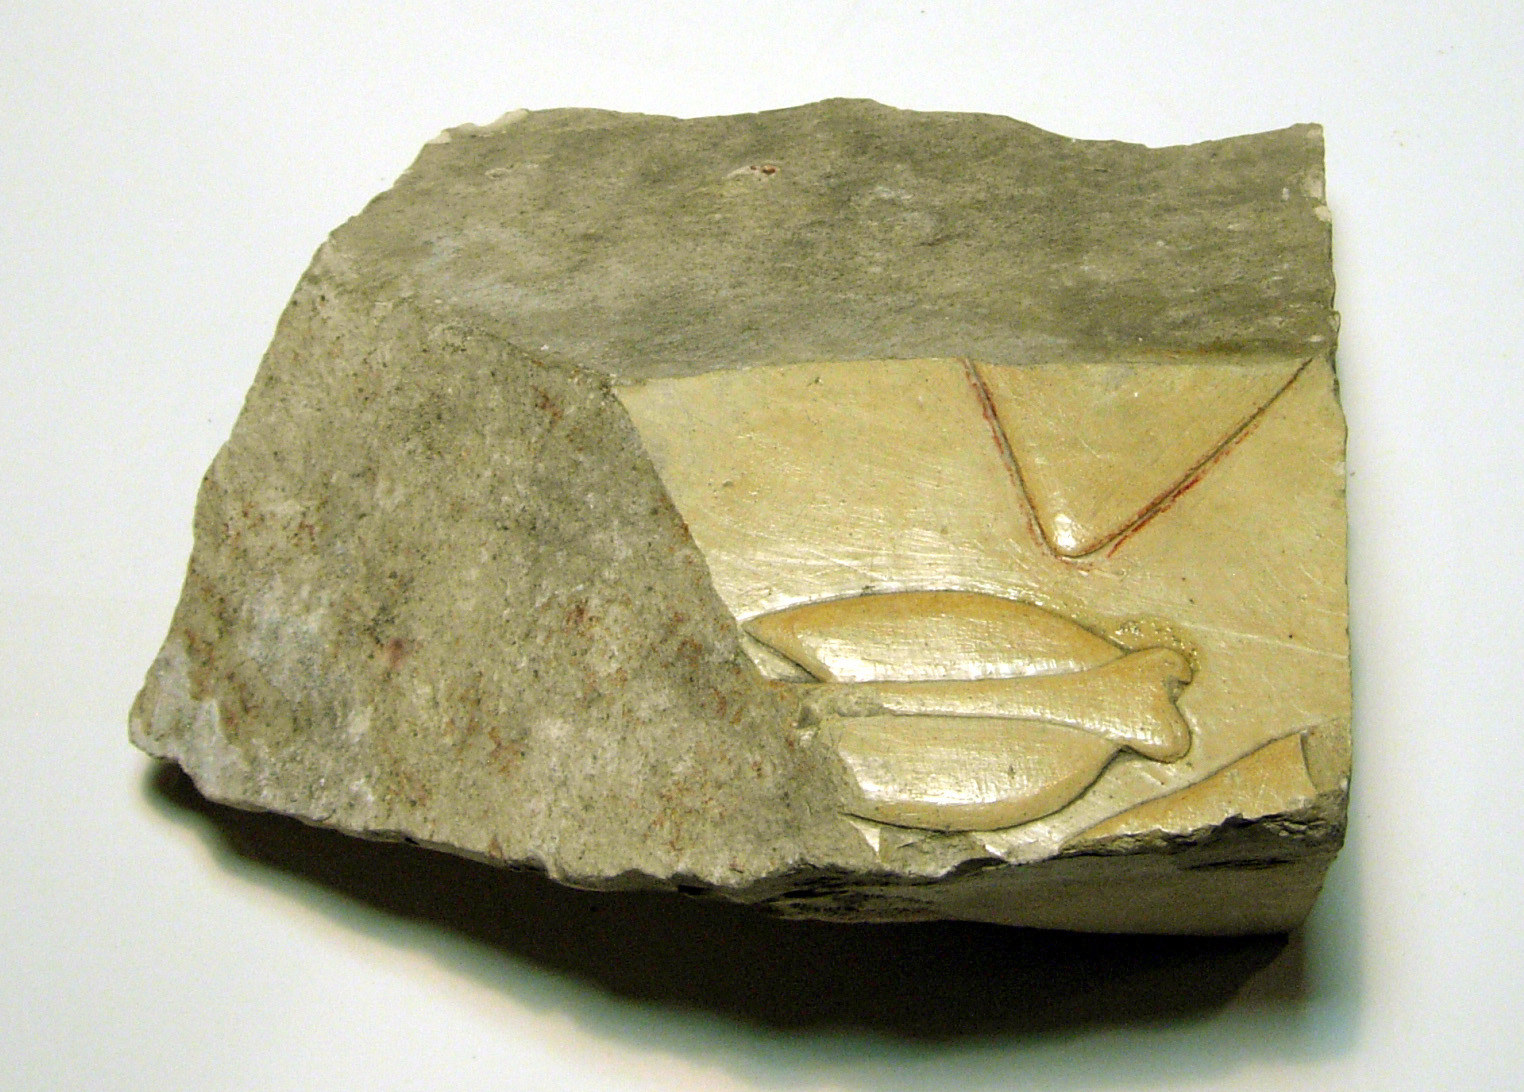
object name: relief, tomb of nespekashuty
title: Raised relief fragment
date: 664-610 BCE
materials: limestone, varnish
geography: egypt